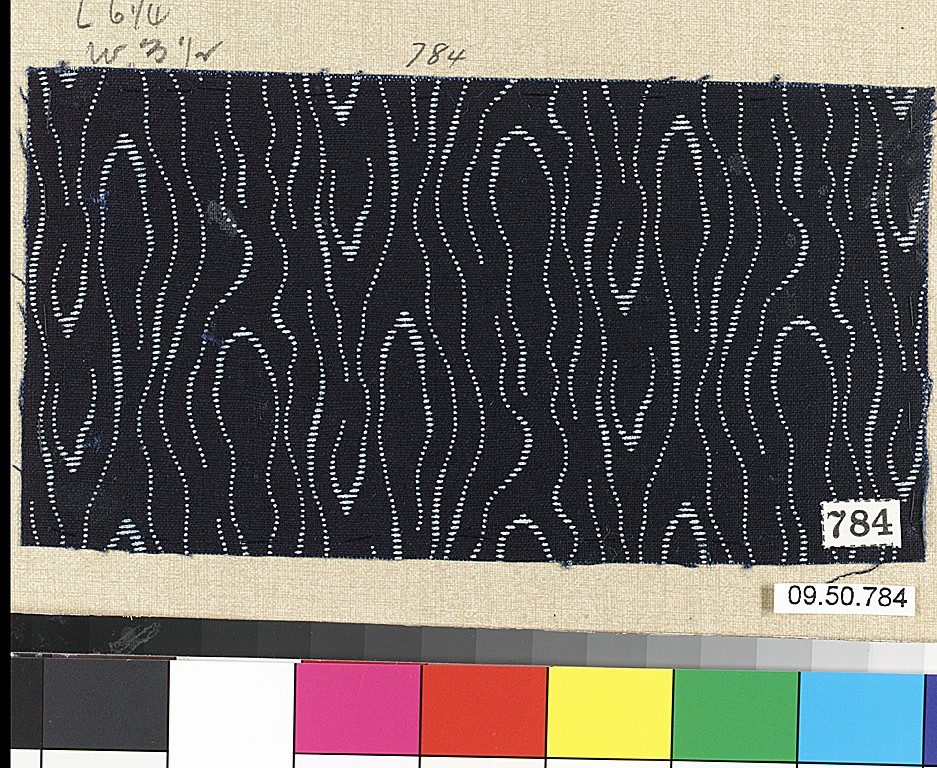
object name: piece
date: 1801-1900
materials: cotton